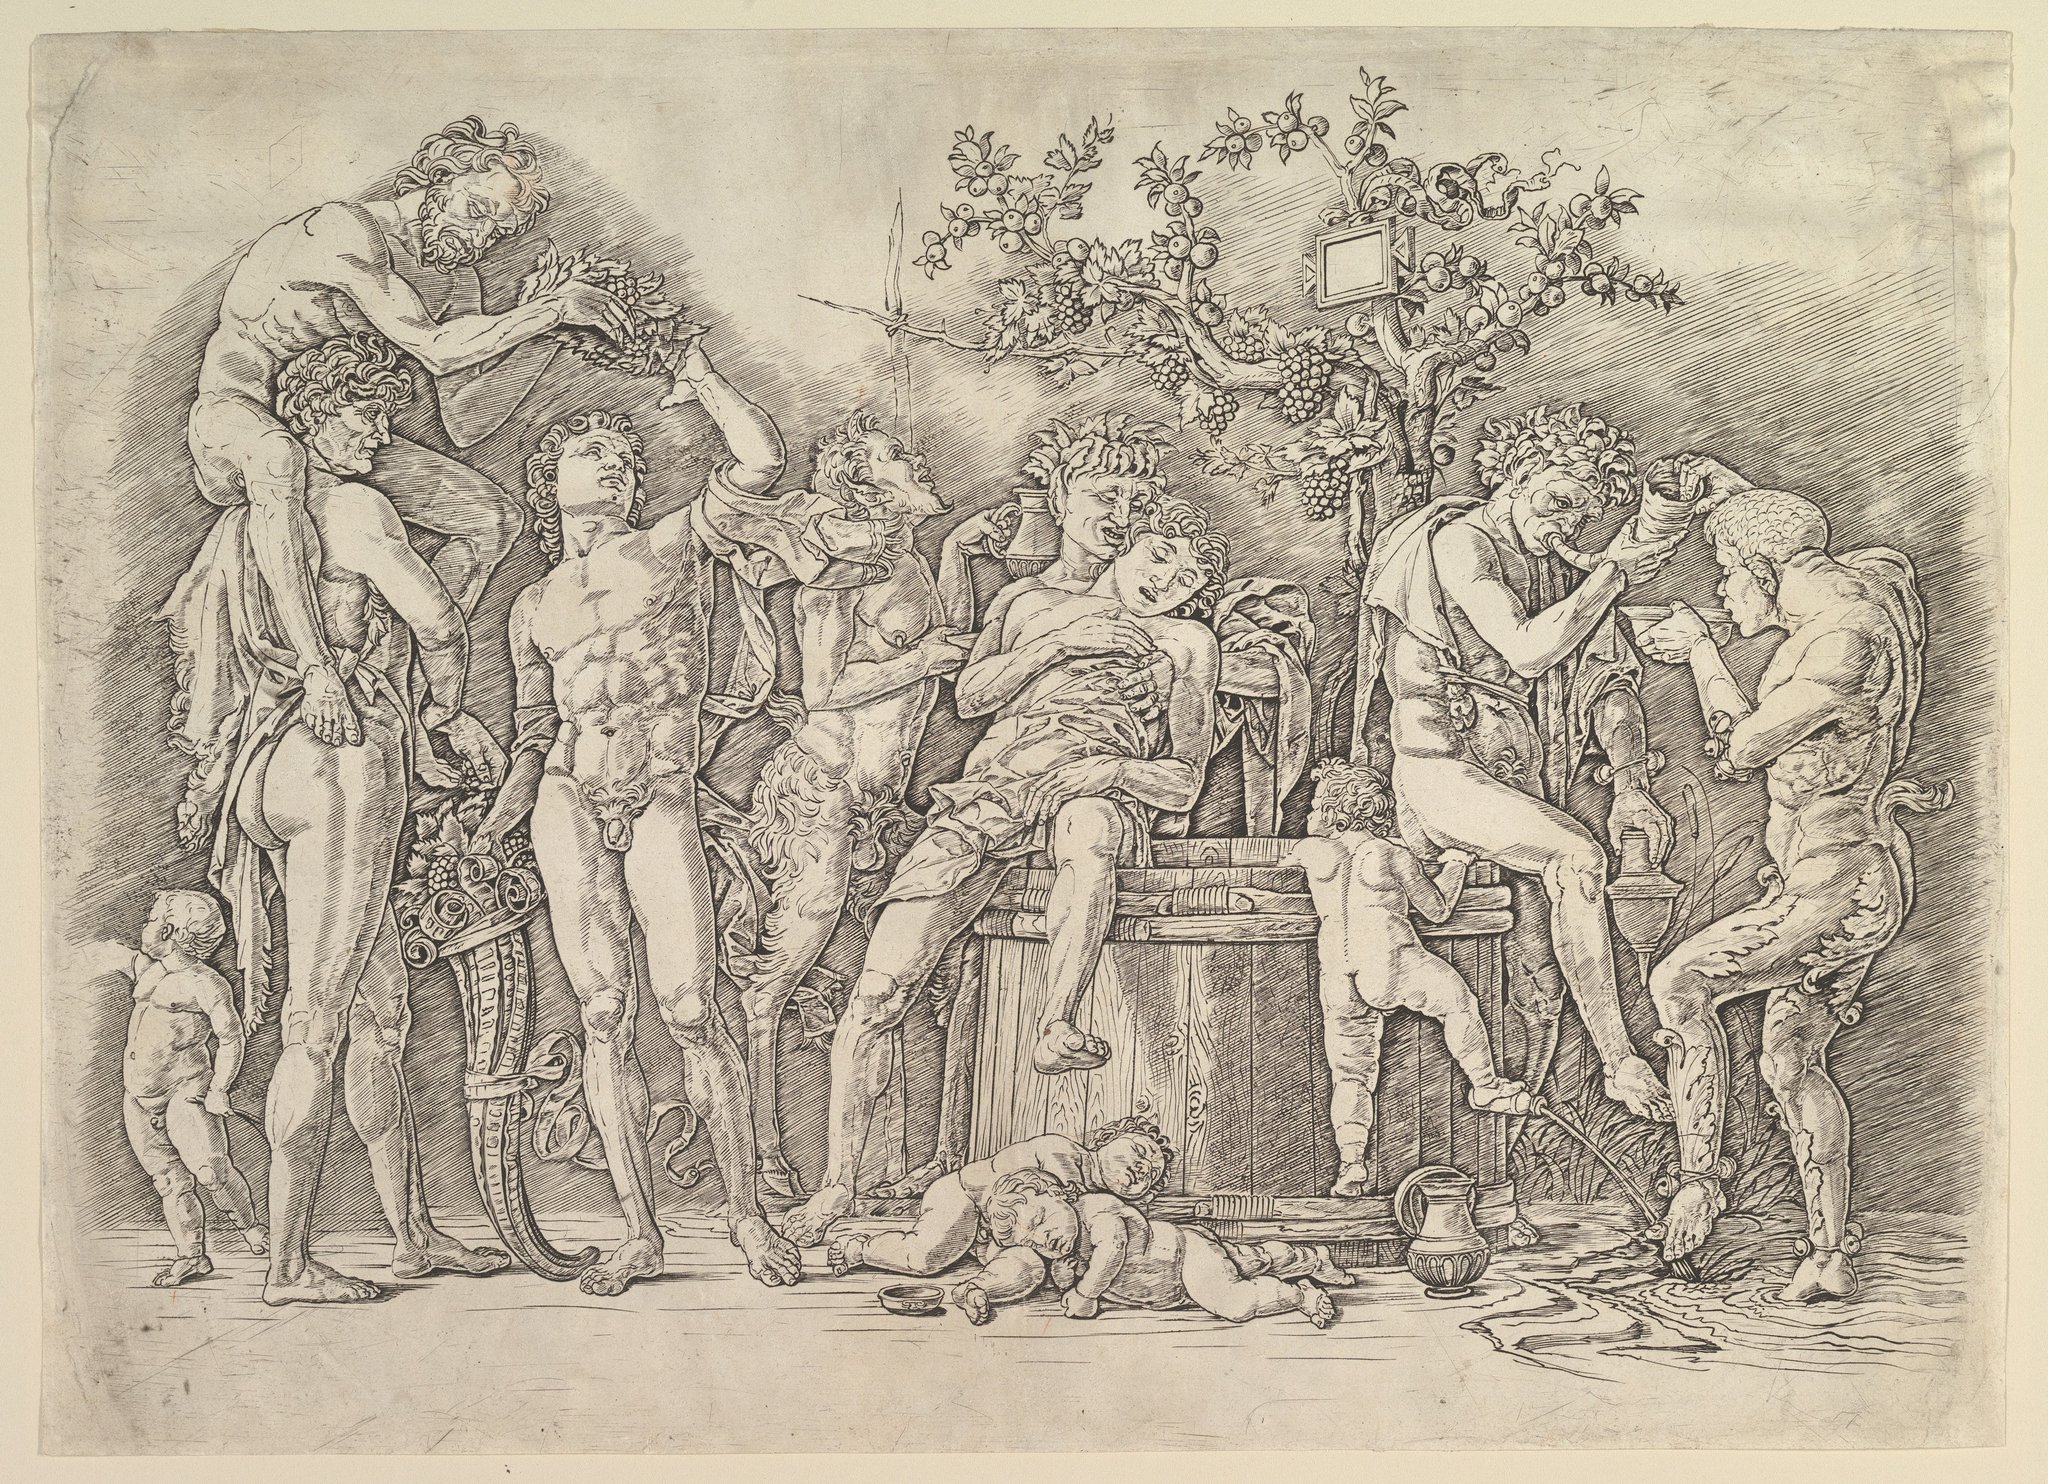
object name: print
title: Bacchanal with Wine Vat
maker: andrea mantegna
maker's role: artist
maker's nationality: italian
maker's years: 1431-1506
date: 1475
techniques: engraving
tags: drunkenness,children,men,satyrs,drinking